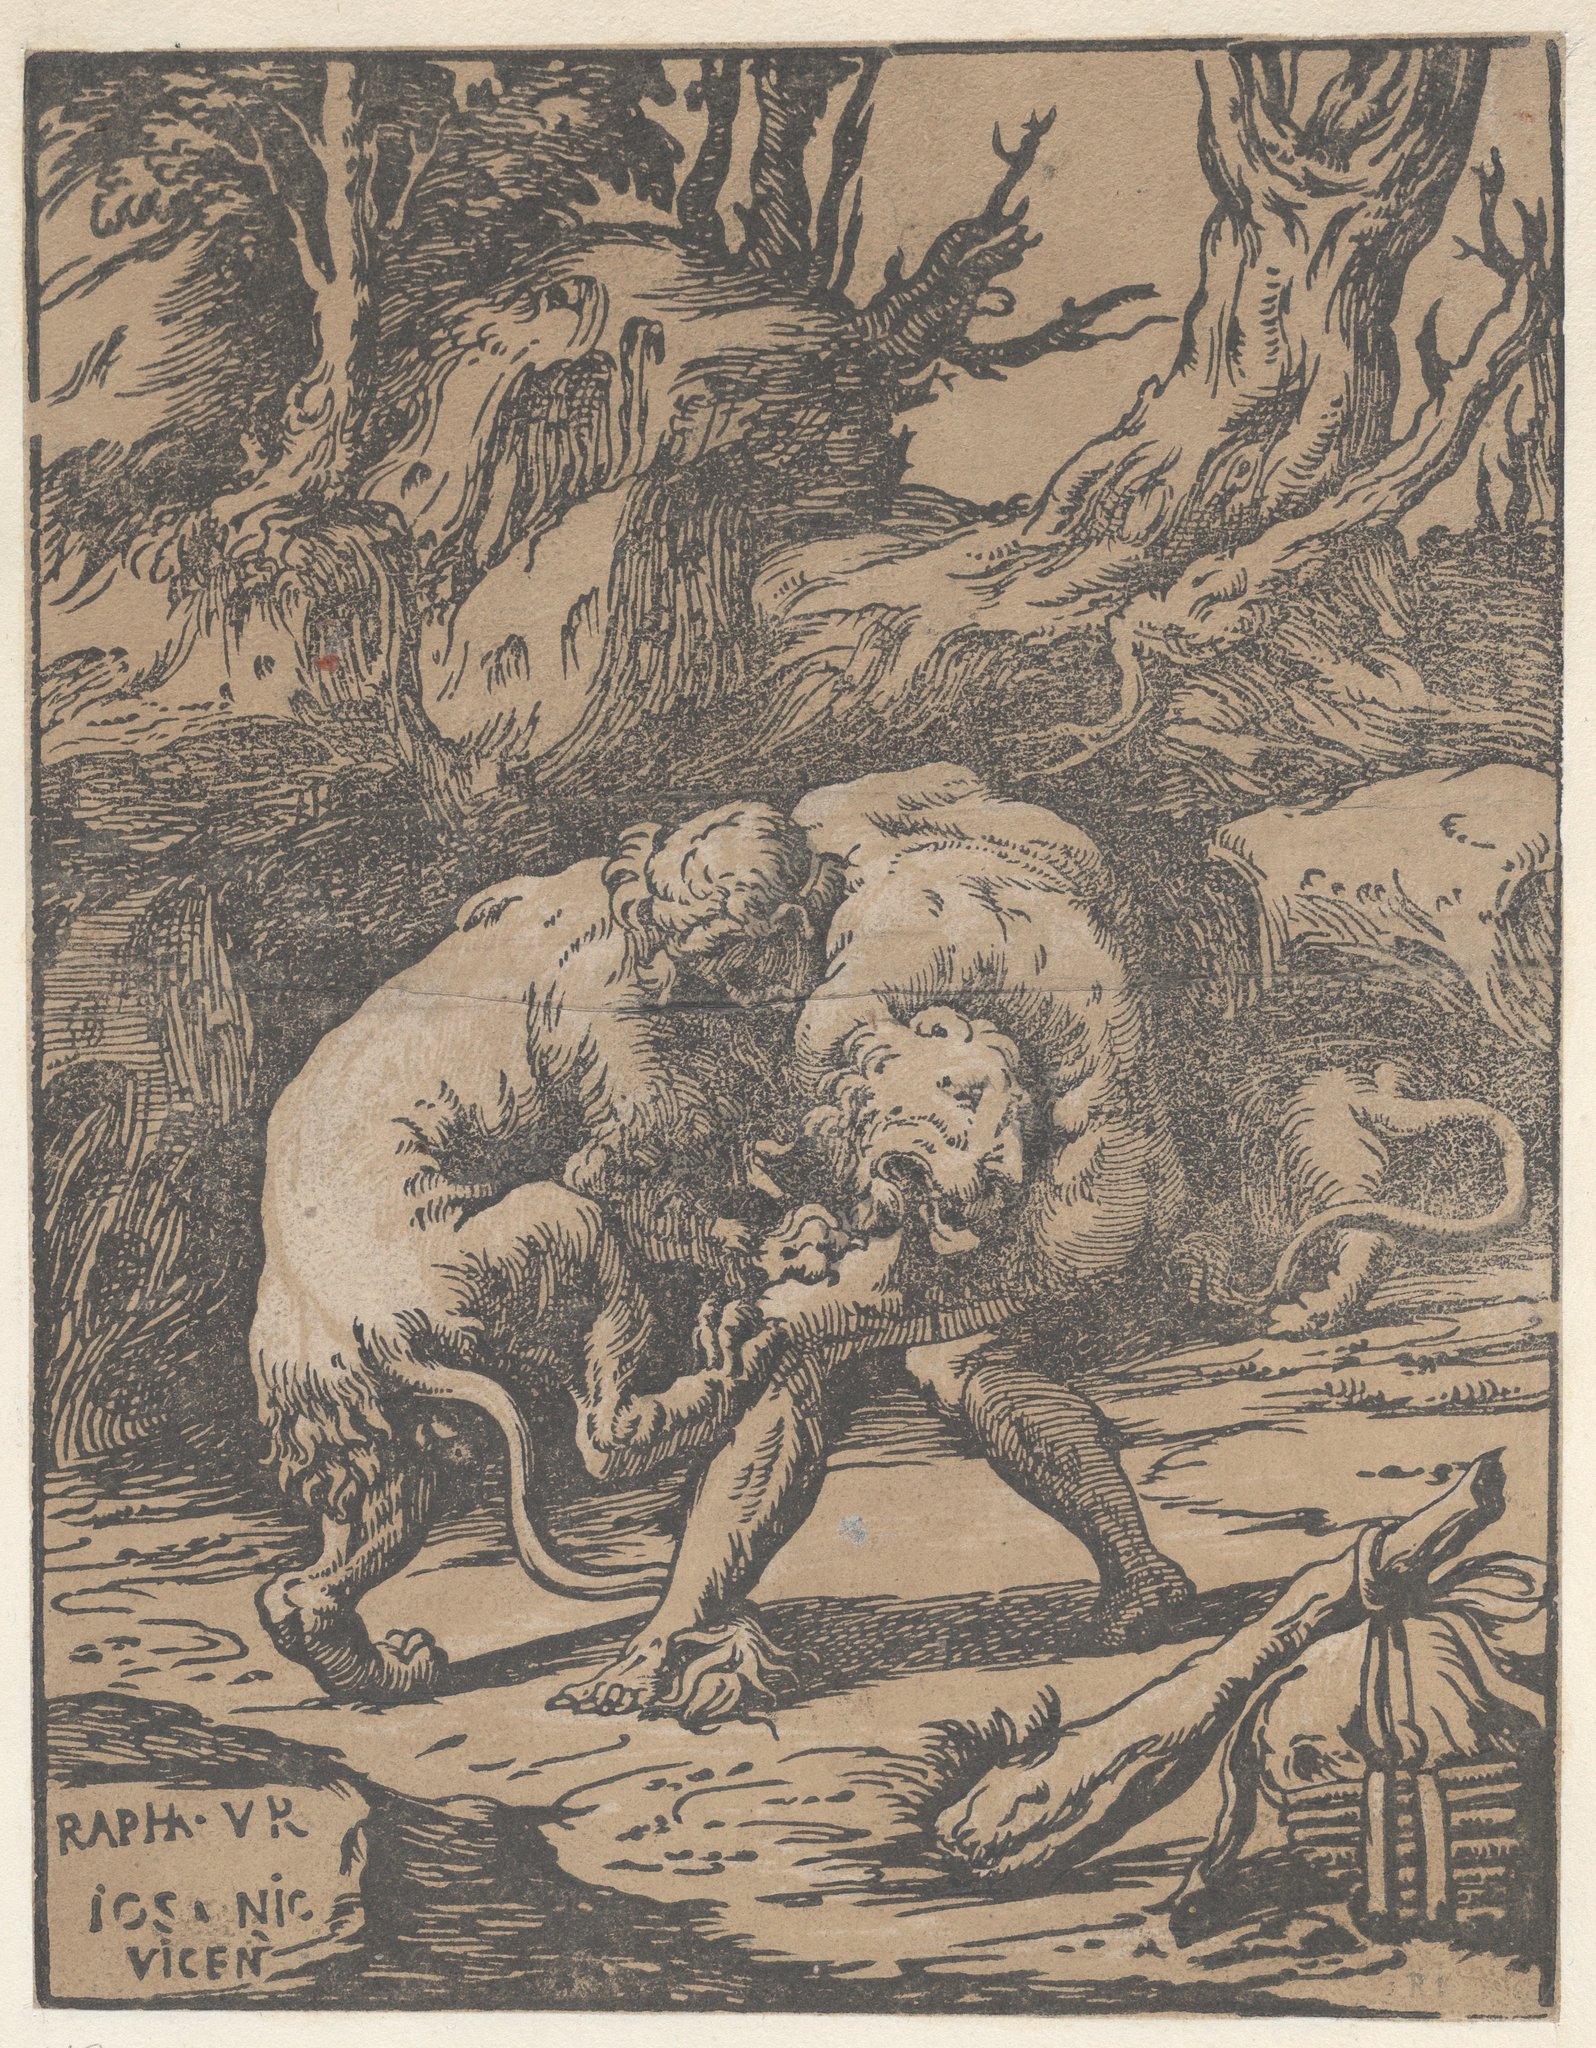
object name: print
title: Hercules and the Nemean Lion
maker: niccolò vicentino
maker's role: artist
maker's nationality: italian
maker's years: 1510-1550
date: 1540-1550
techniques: woodcut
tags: hercules,lions